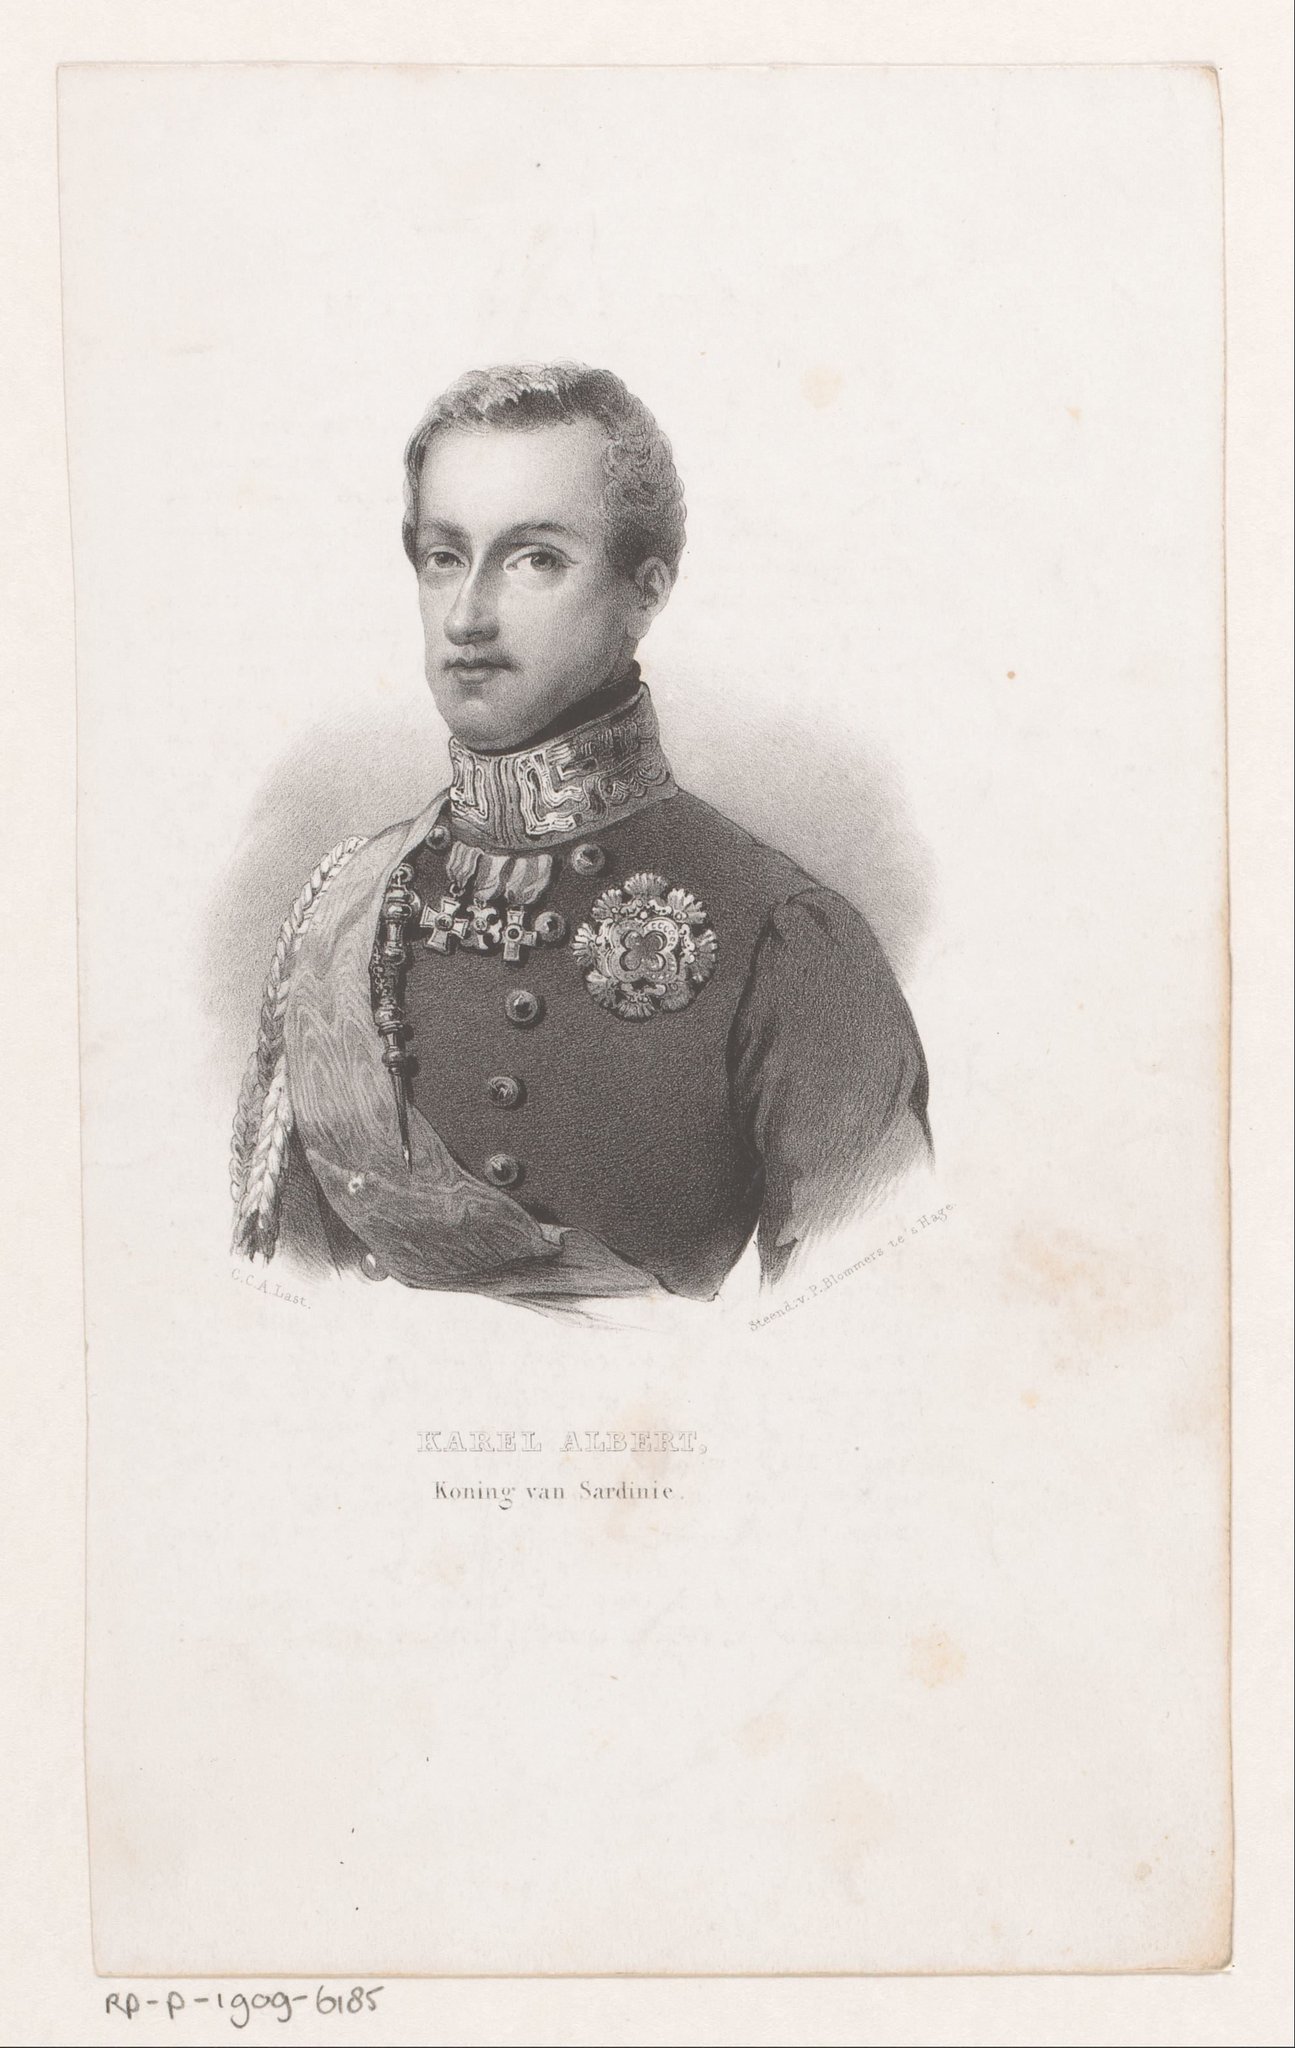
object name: print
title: Portret van Koning Karel Albert van Sardinië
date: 1842-1887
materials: paper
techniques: lithograph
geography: netherlands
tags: historical persons (+ (full) bust portrait)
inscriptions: collector's mark: Lugt 2228